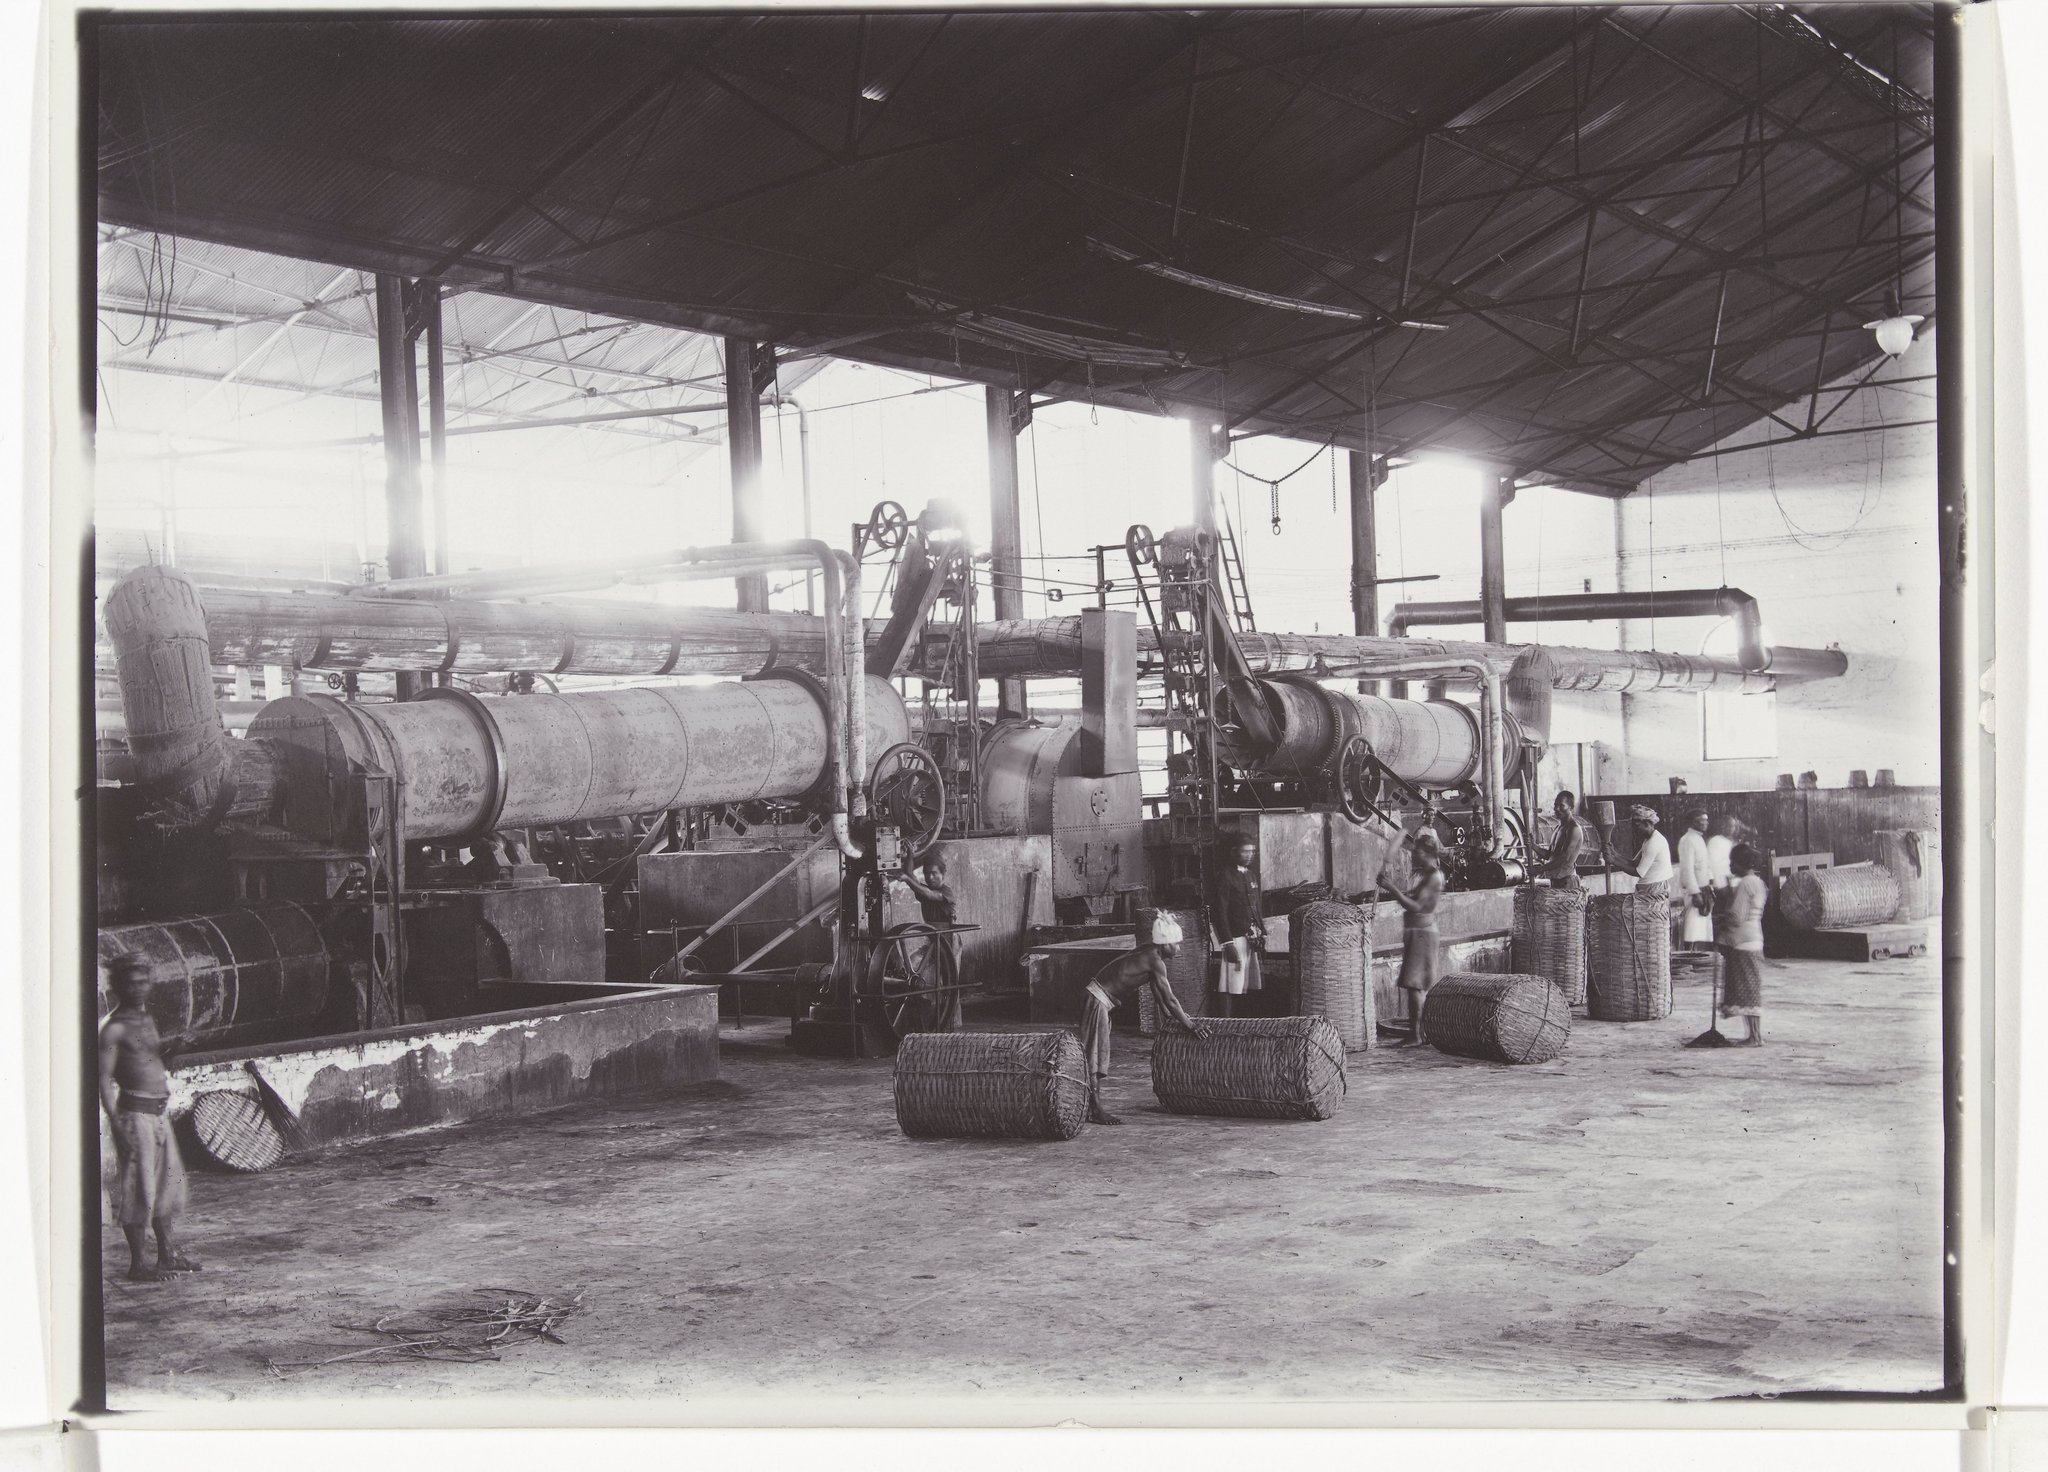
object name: photograph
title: Interieur van de suikerfabriek van de suikeronderneming Nieuw Tersana, Cheribon, voormalig Nederlands-Indië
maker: onnes kurkdjian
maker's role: fotograaf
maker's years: 1851-1903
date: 1890-1911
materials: paper, photographic support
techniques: gelatin silver print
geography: cirebon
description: Interieur van de suikerfabriek van de suikeronderneming Nieuw Tersana, Cheribon, voormalig Nederlands-Indië. Mannen zijn bezig met het vullen van rieten manden.